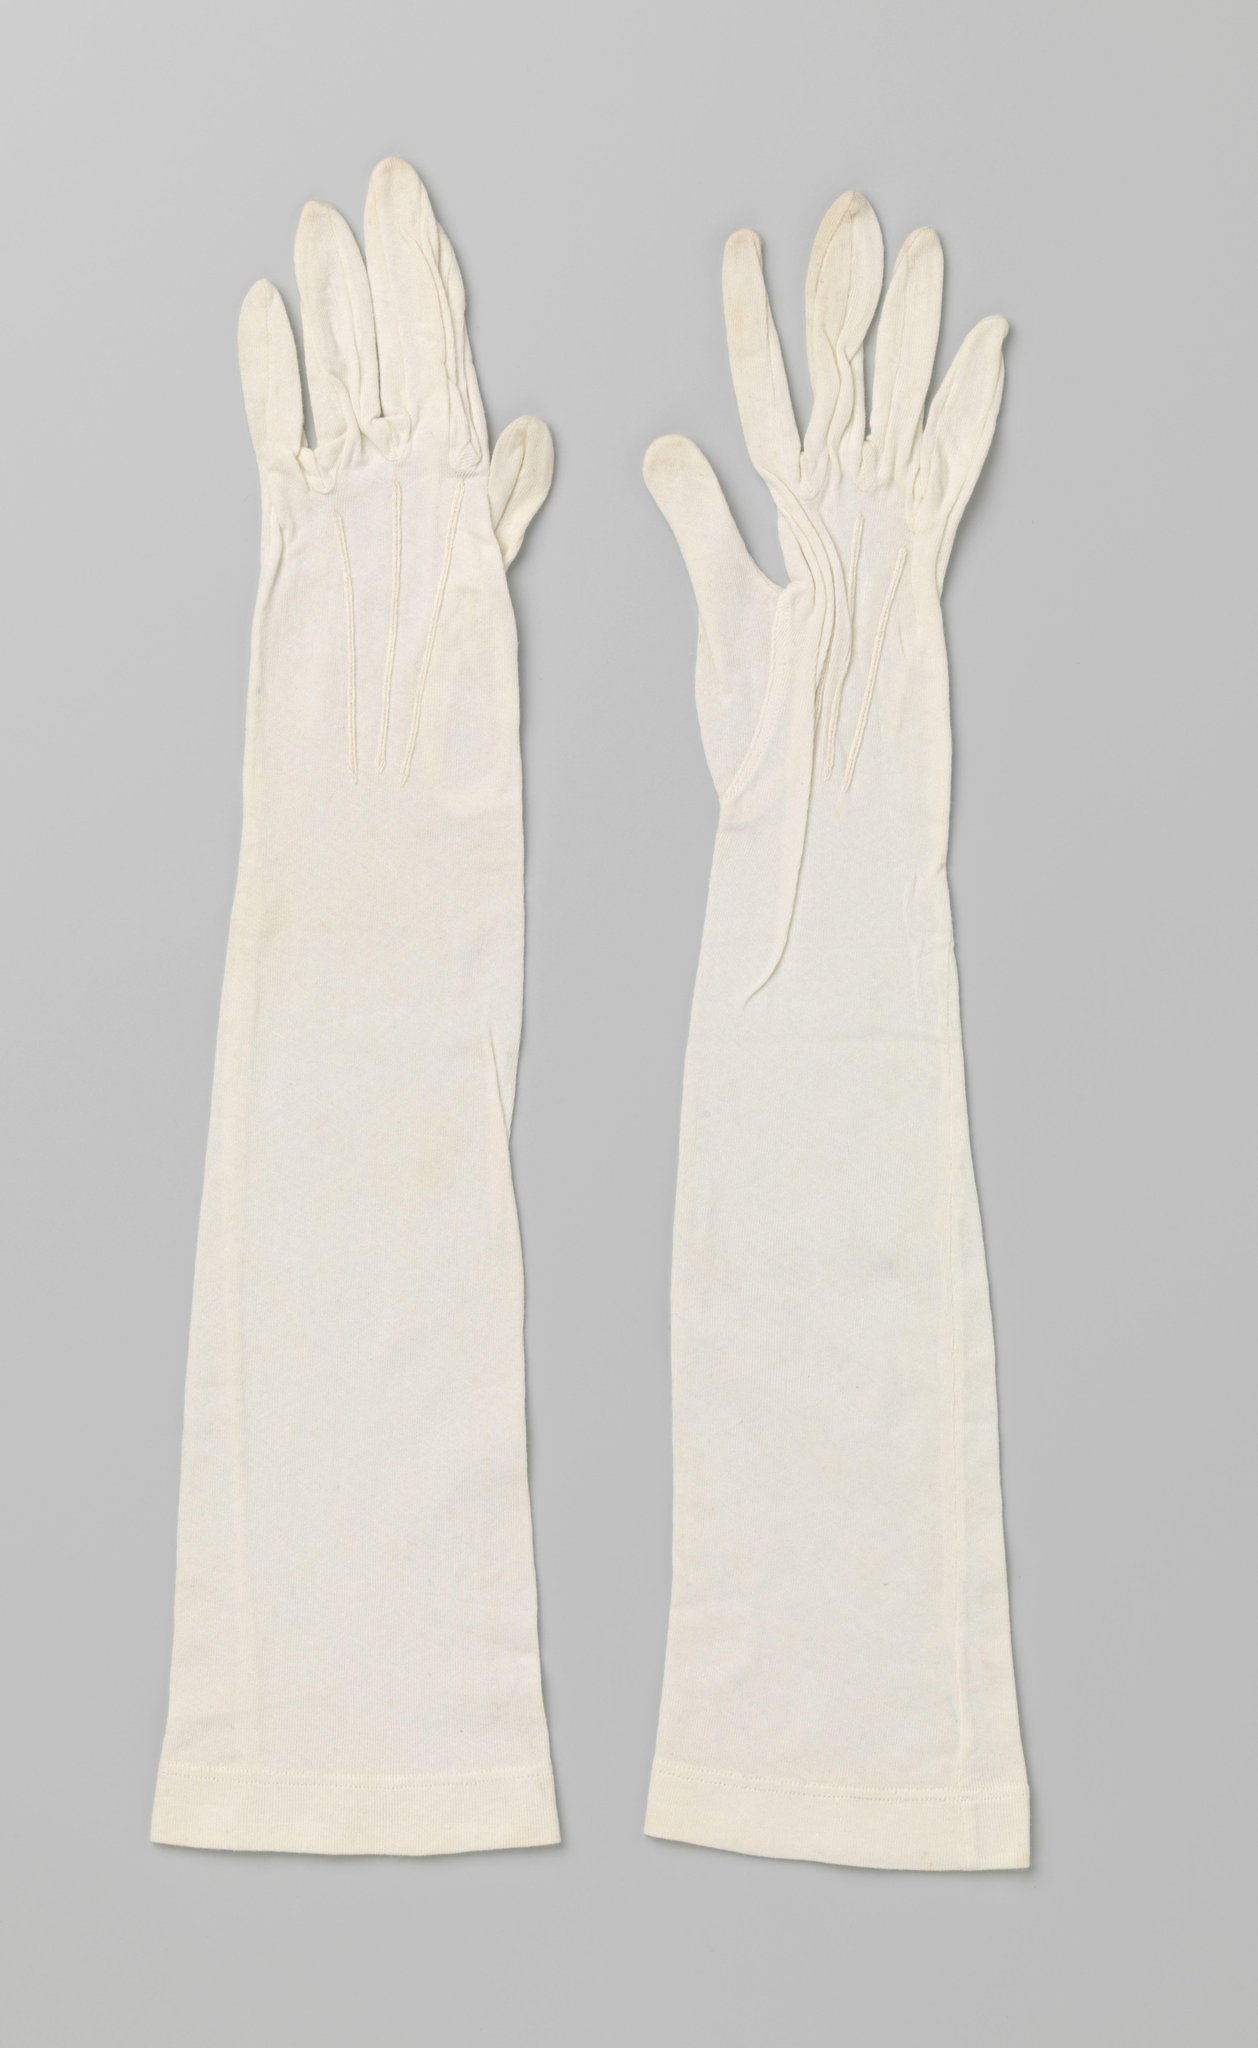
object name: glove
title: Handschoen van witte katoenen tricot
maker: Anonymous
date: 1950-1960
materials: cotton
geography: netherlands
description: Rechter handschoen van witte katoenen tricot. Op de rug drie uitstralende koorden.